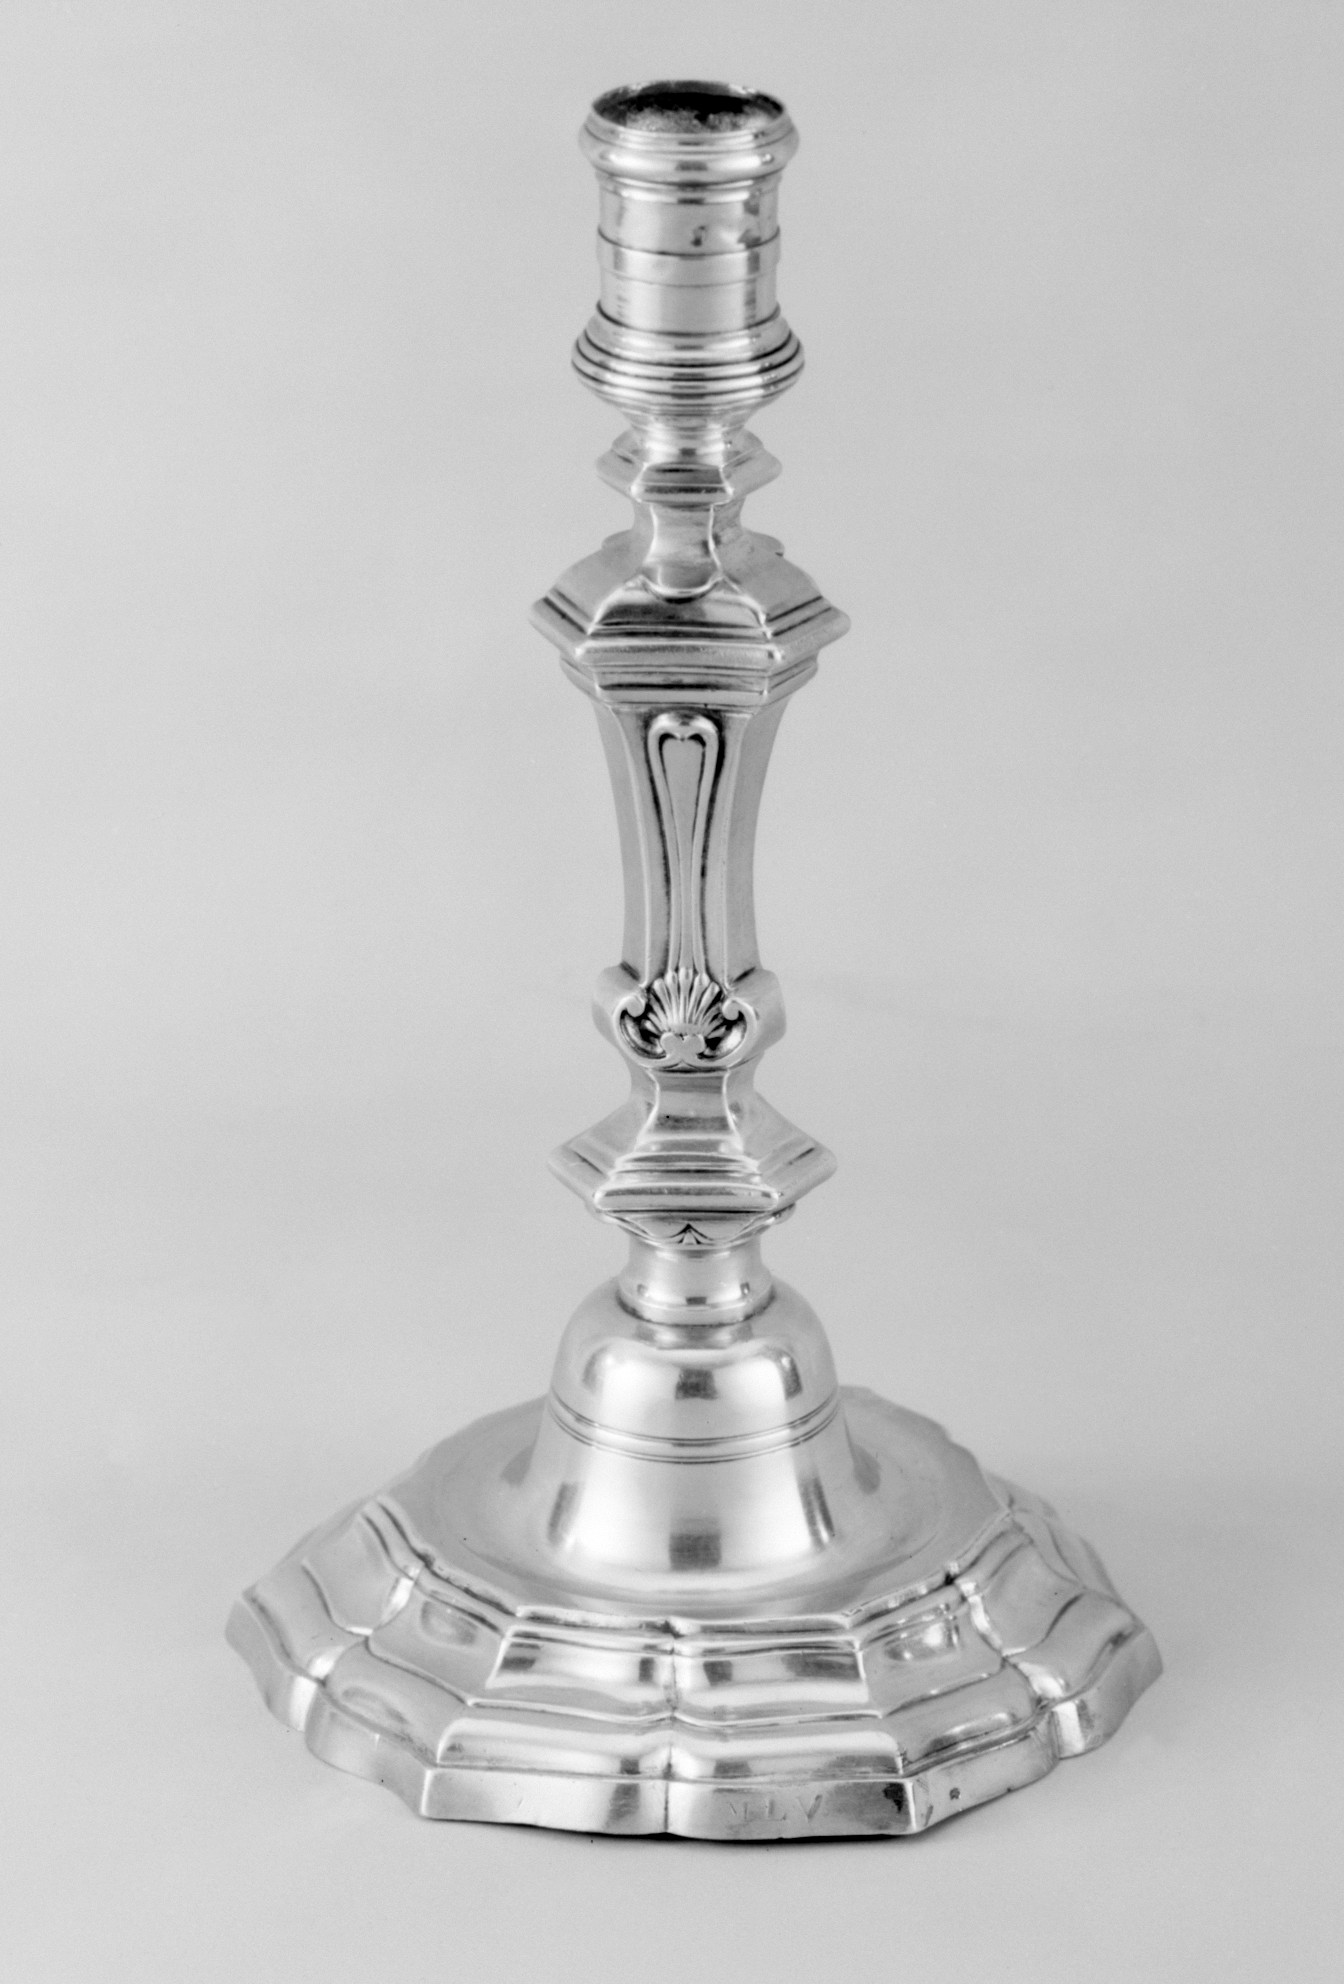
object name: candlestick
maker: jean-françois balzac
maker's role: maker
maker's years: 1711-1766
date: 1756-1757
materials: silver